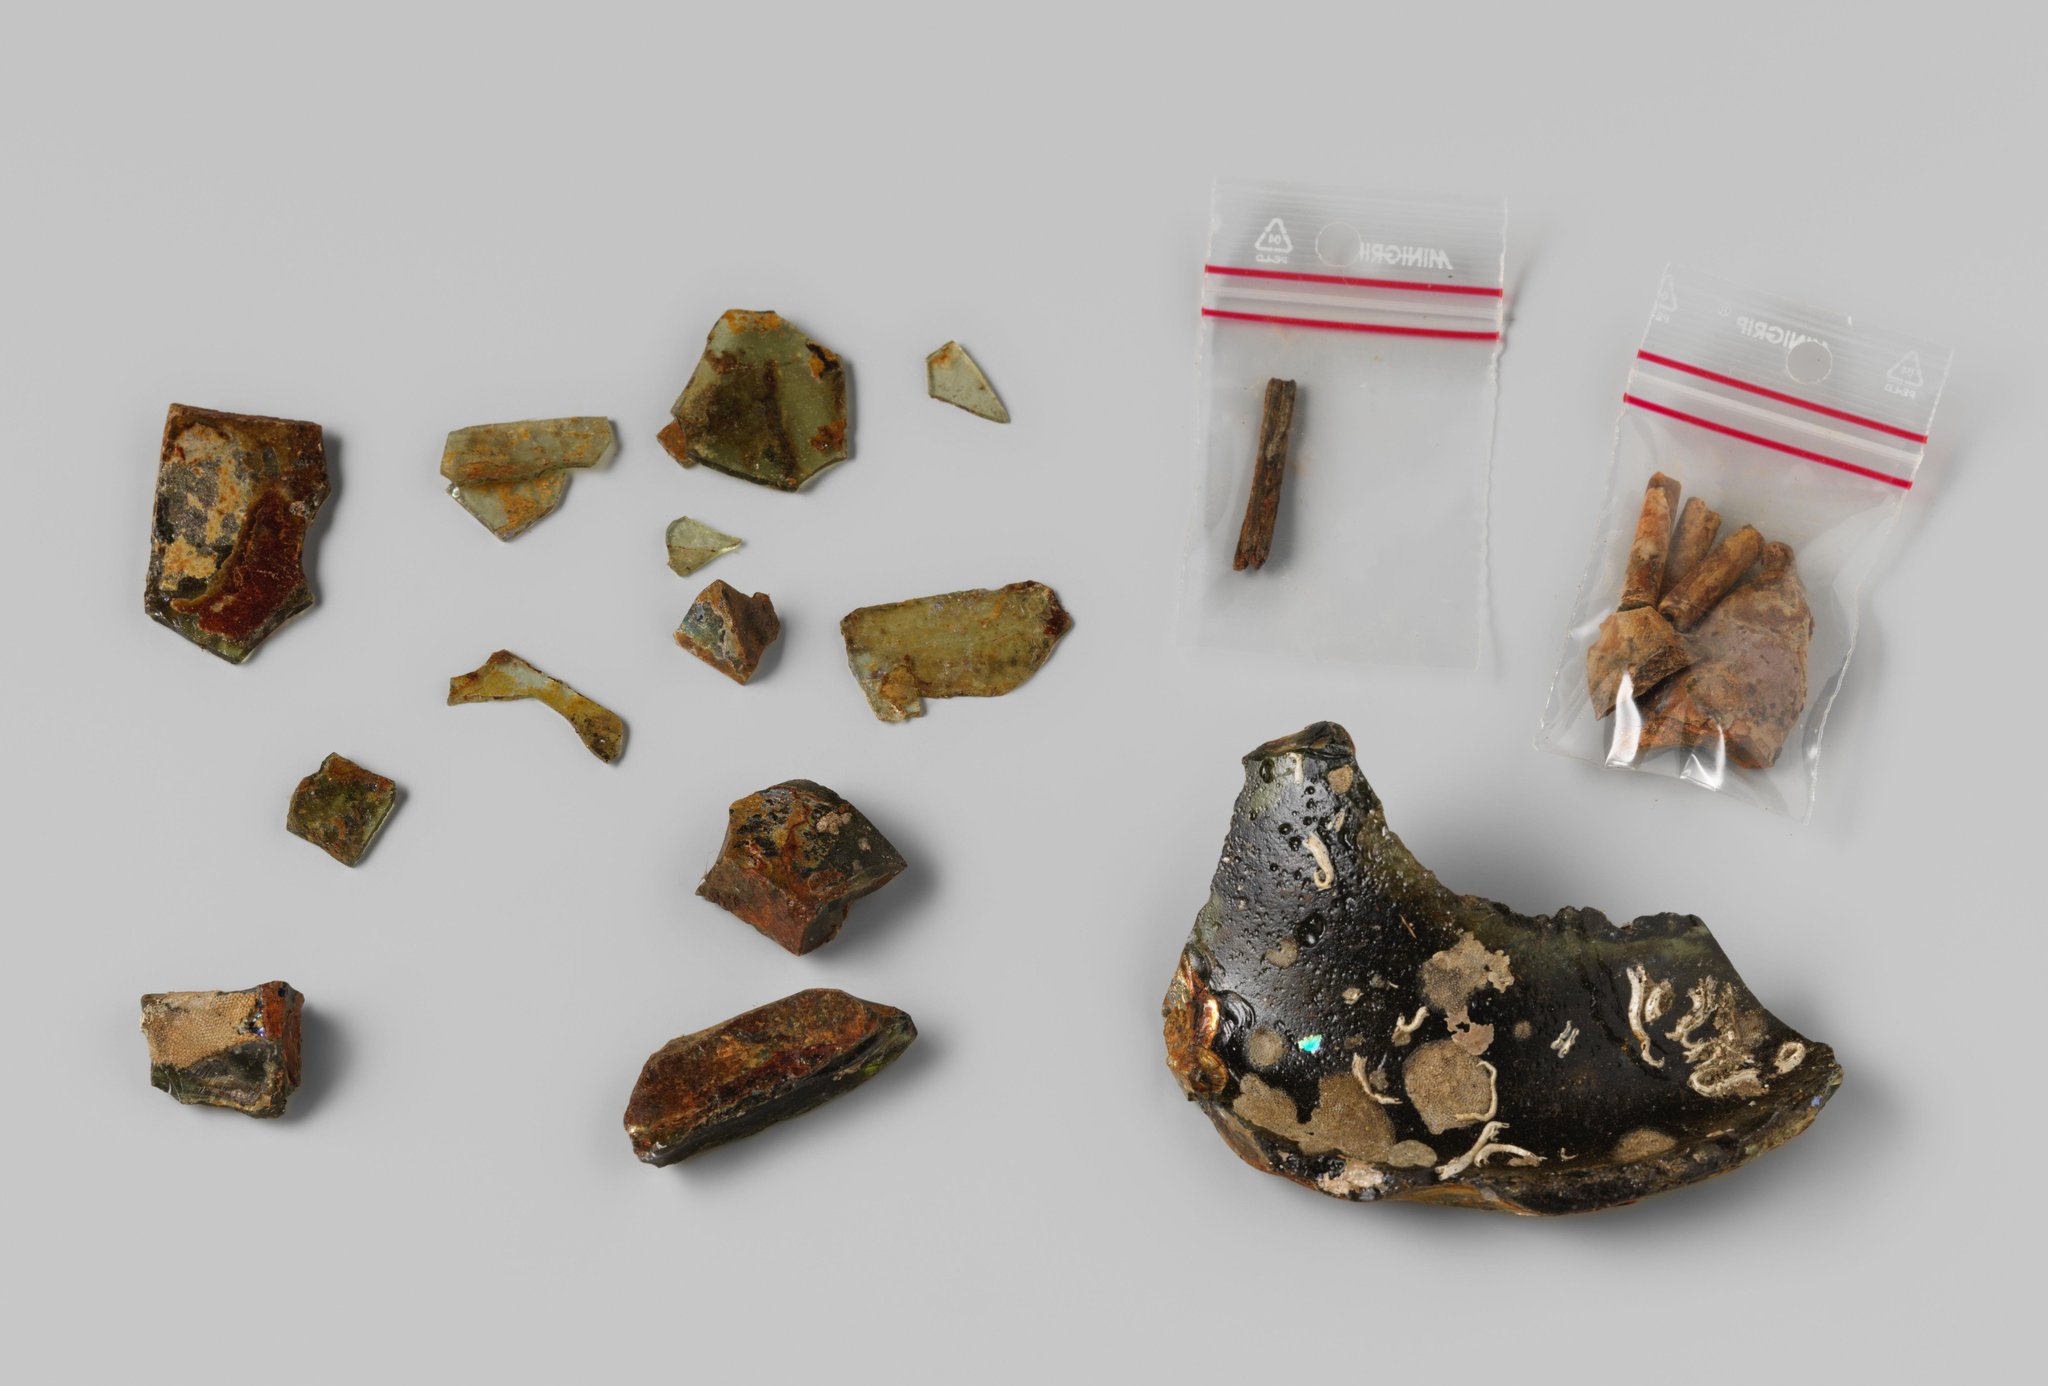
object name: sherd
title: Fragmenten pijpenstelen en pijpenkoppen, glasscherven en houtfragment uit het wrak van de Oostindiëvaarder Hollandia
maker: Anonymous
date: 1700-1743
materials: glass, clay, wood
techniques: green glass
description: 15 glasscherven, 2 pijpenkopfragmenten, 3 fragmenten pijpensteel, 1 houtfragment.